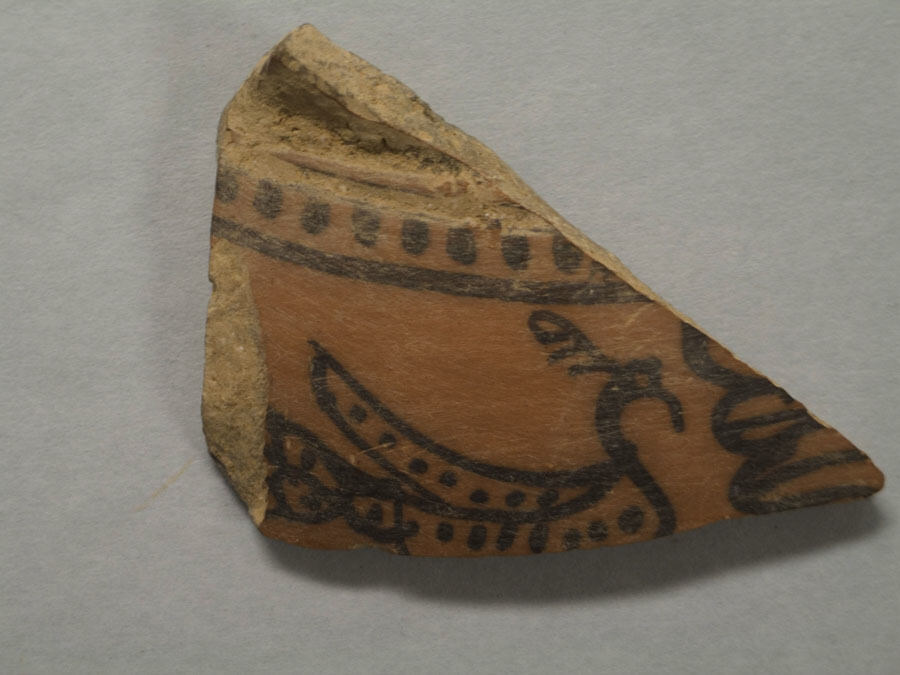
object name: shard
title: Shard:Torso of a Bird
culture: pakistani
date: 301-500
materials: terracotta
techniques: painting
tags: birds,gandhara